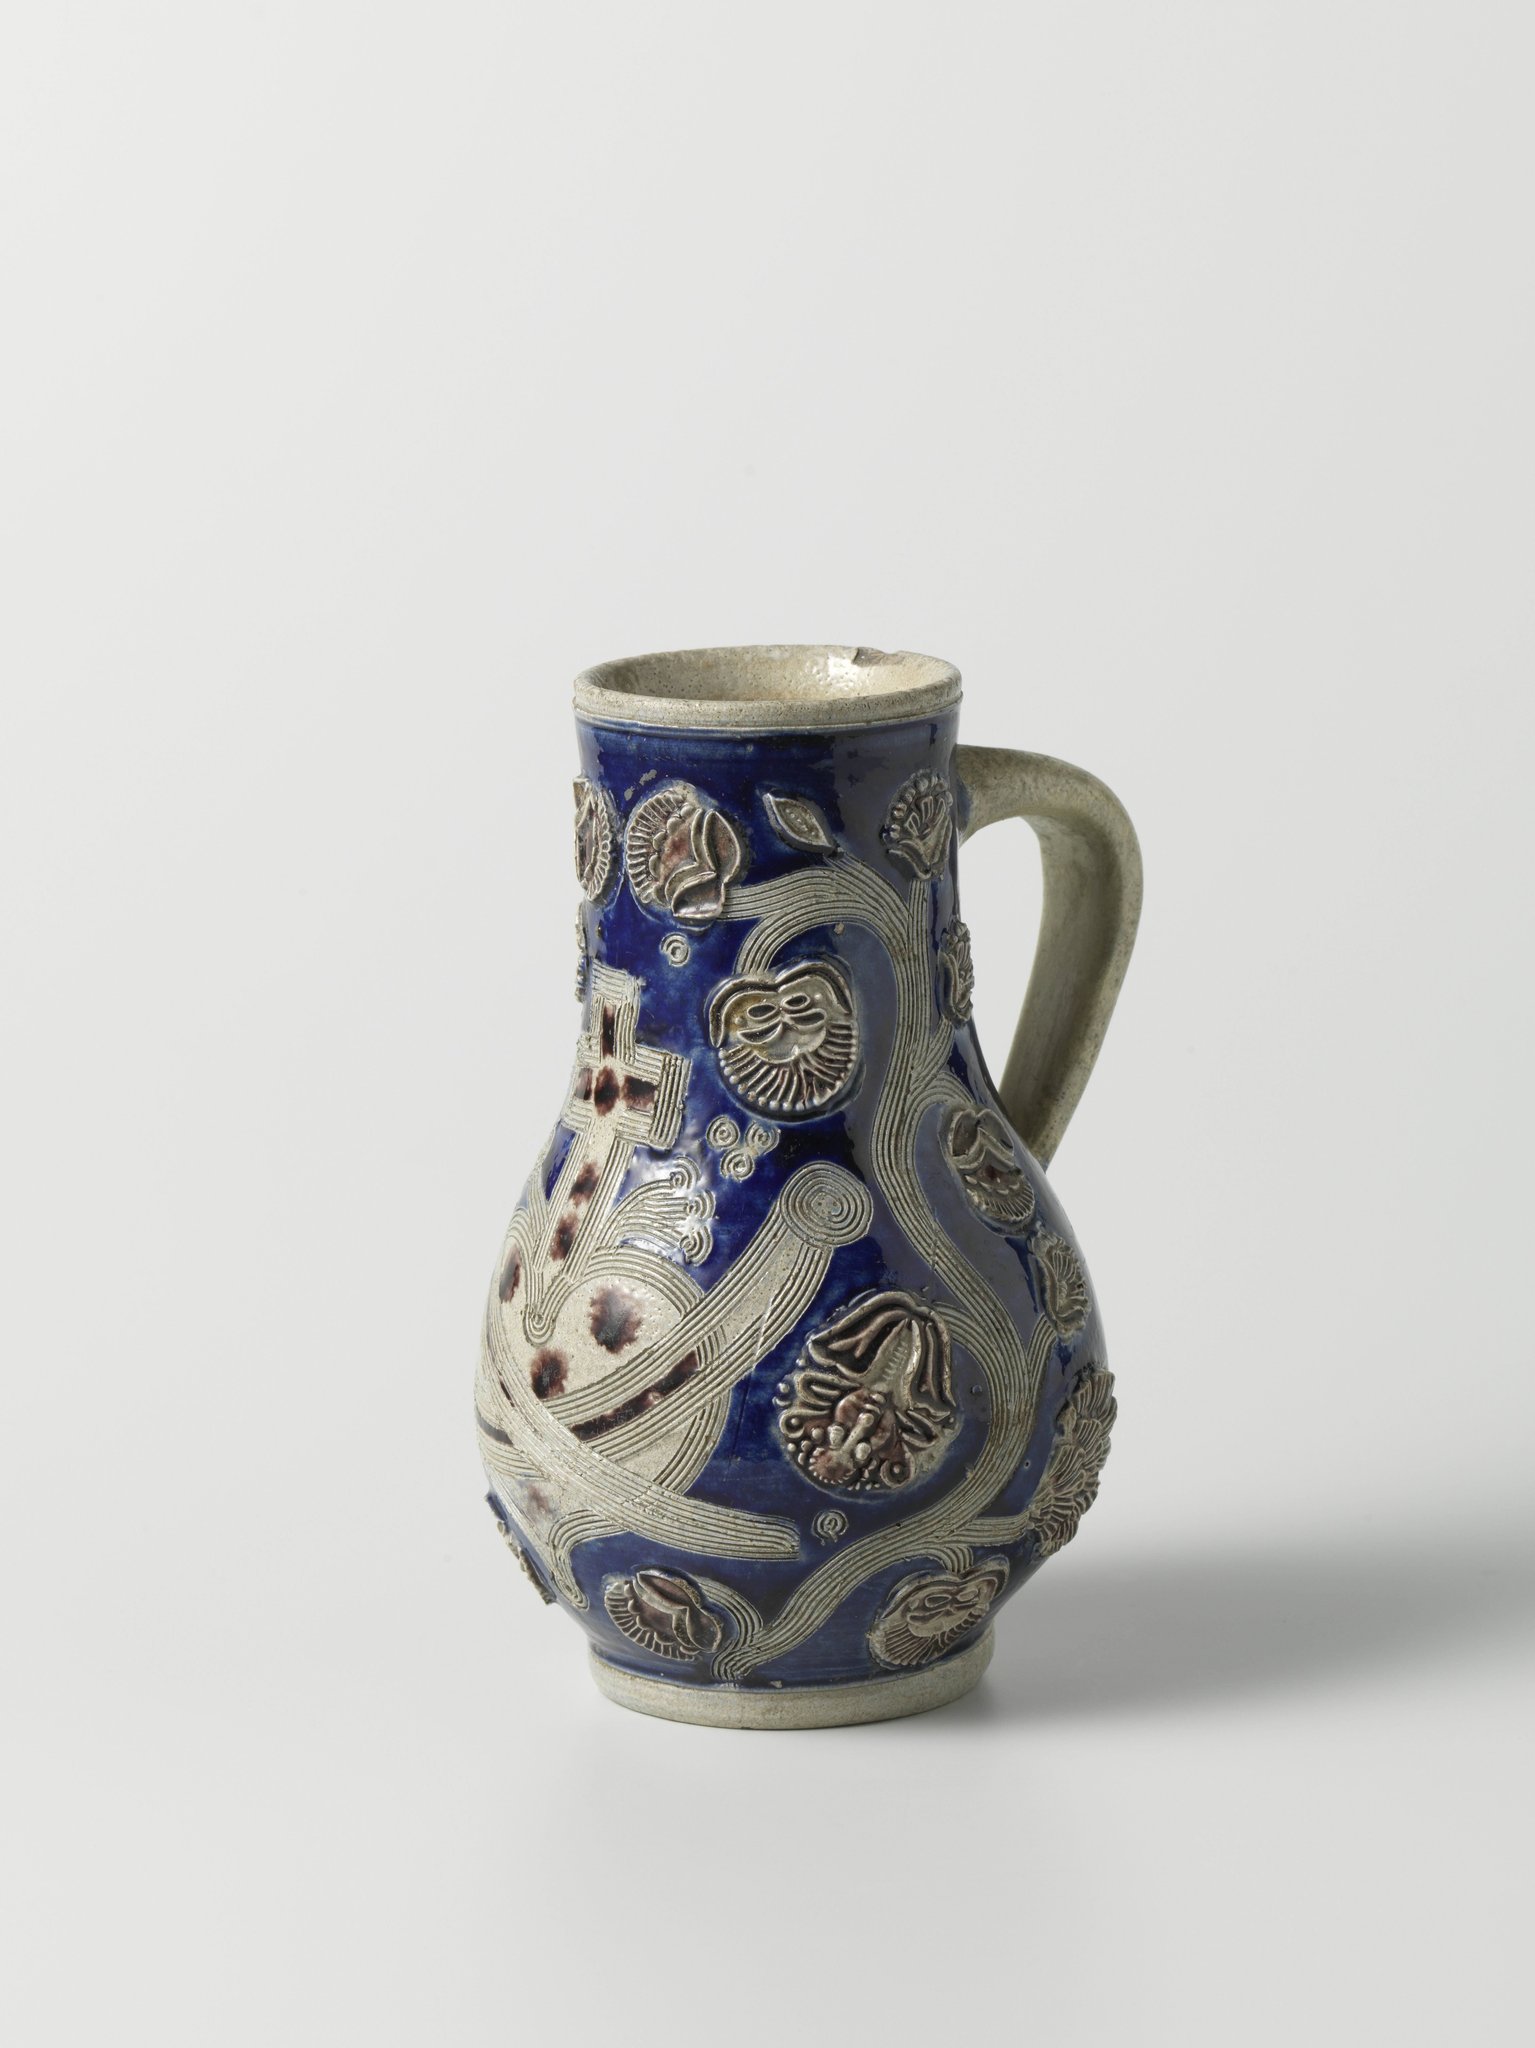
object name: jug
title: Jug with a cross above a heart among floral scrolls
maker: Anonymous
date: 1680-1750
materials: cobalt, glaze, mineral, stoneware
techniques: firing, forming, relief, turning, vitrification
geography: westerwald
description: Kruik van steengoed op standring met een peervormig lichaam en wijde nek. Het C-vormige oor is bevestigd aan de nek en de schouder. Gedeeltelijk bedekt met kobaltblauw en mangaanpaars. De kan is versierd met een ingegrift kruis boven een hart tussen bloemranken. De bloemranken bestaan uit ingegrifte stelen en gedrukte en opgelegde bloemen in reliëf. Westerwald.